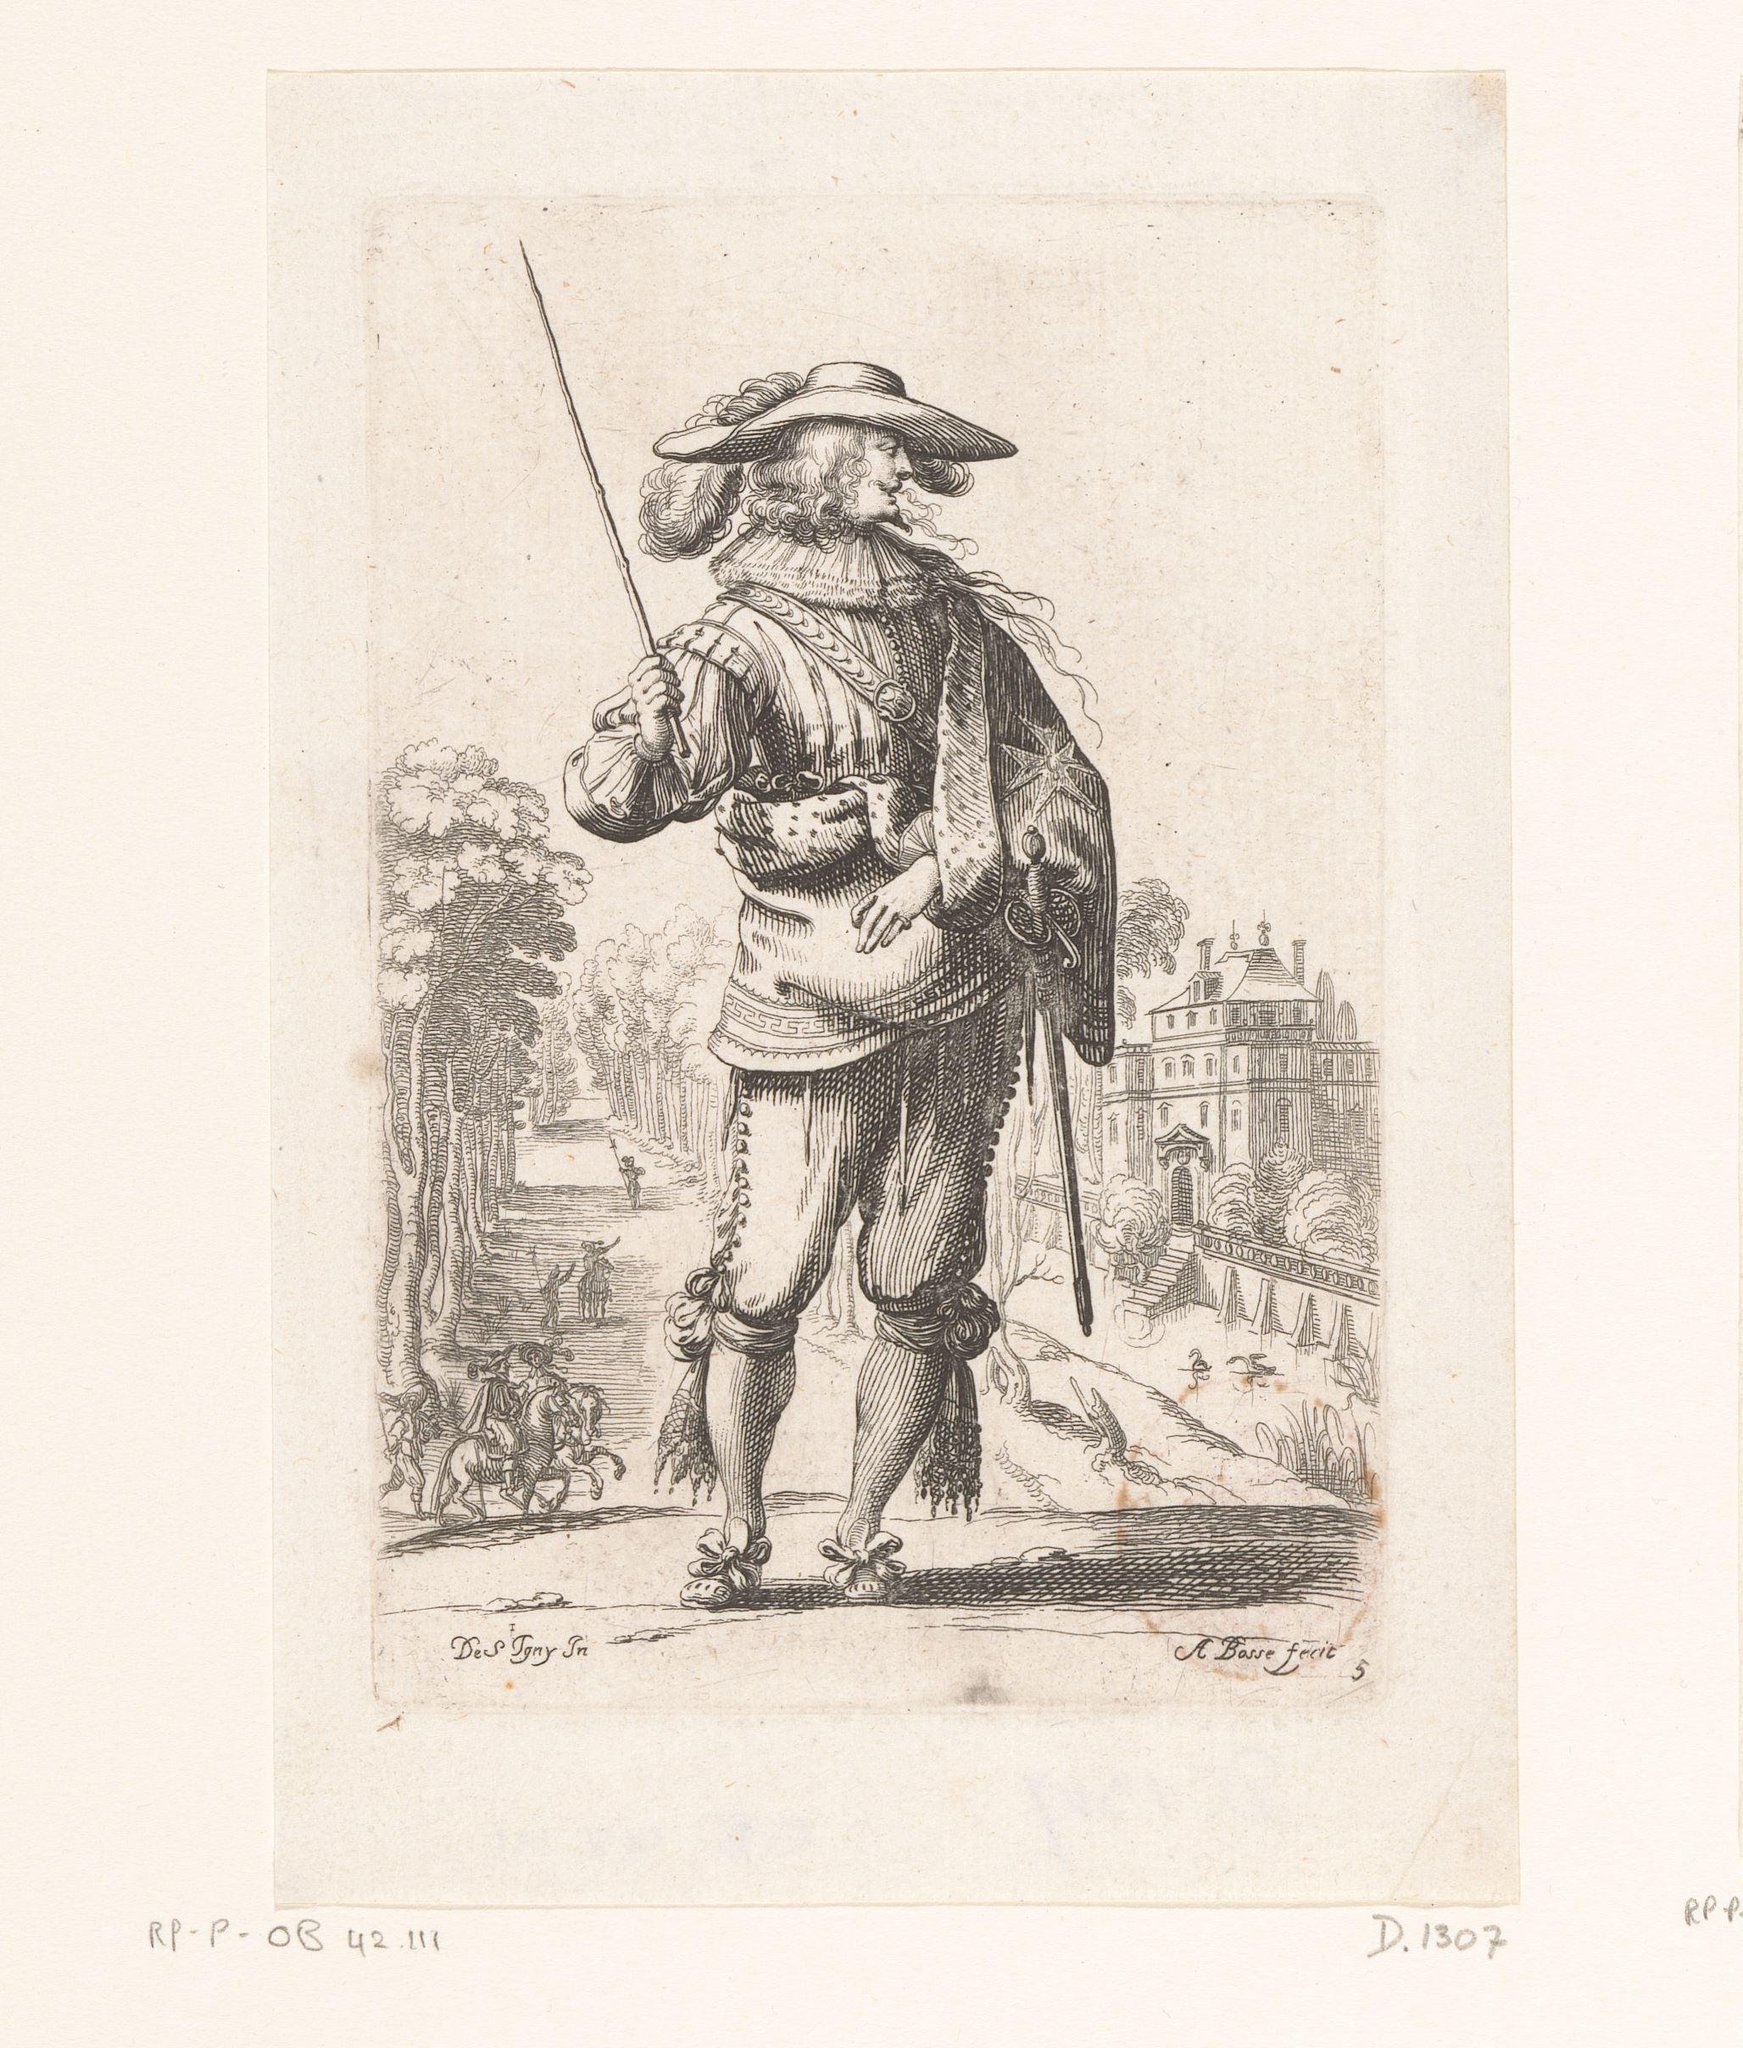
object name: costume print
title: Franse edelman, behorend tot de orde van Saint Esprit, gekleed volgens de mode van ca. 1630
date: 1629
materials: paper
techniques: engraving, etching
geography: paris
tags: moustache, head-gear: hat (+ men's clothes), europeans (with name), shoes, sandals (+ men's clothes), clothes, costume (+ men's clothes), knighthood order of the holy spirit, neck-gear: collar (+ men's clothes), trousers, breeches, etc. (breeches) (+ men's clothes), clothing for the upper part of the body (doublet) (+ men's clothes), hacking and thrusting weapons (foil), knighthood order of the holy spirit - insignia of a knighthood order, e.g.: badge, chain (with name of order), stockings, socks (+ men's clothes), beard, head-gear: hat (+ feathers used for clothes), whip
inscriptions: collector's mark: Lugt 240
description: Edelman behorend tot de orde van Saint-Esprit, in de rechterhand een opgeheven karwats. Hij draagt een wambuis met platte kraag en een schoudermantel, waarop het kruis van de Orde van Saint Esprit is geborduurd. Kuitbroek met strikken en schoenen met strikken. Hoed met pluim op het lange gekrulde haar. Degen langszij. Op de achtergrond een laan met ruiters; rechts een kasteel met slotgracht.